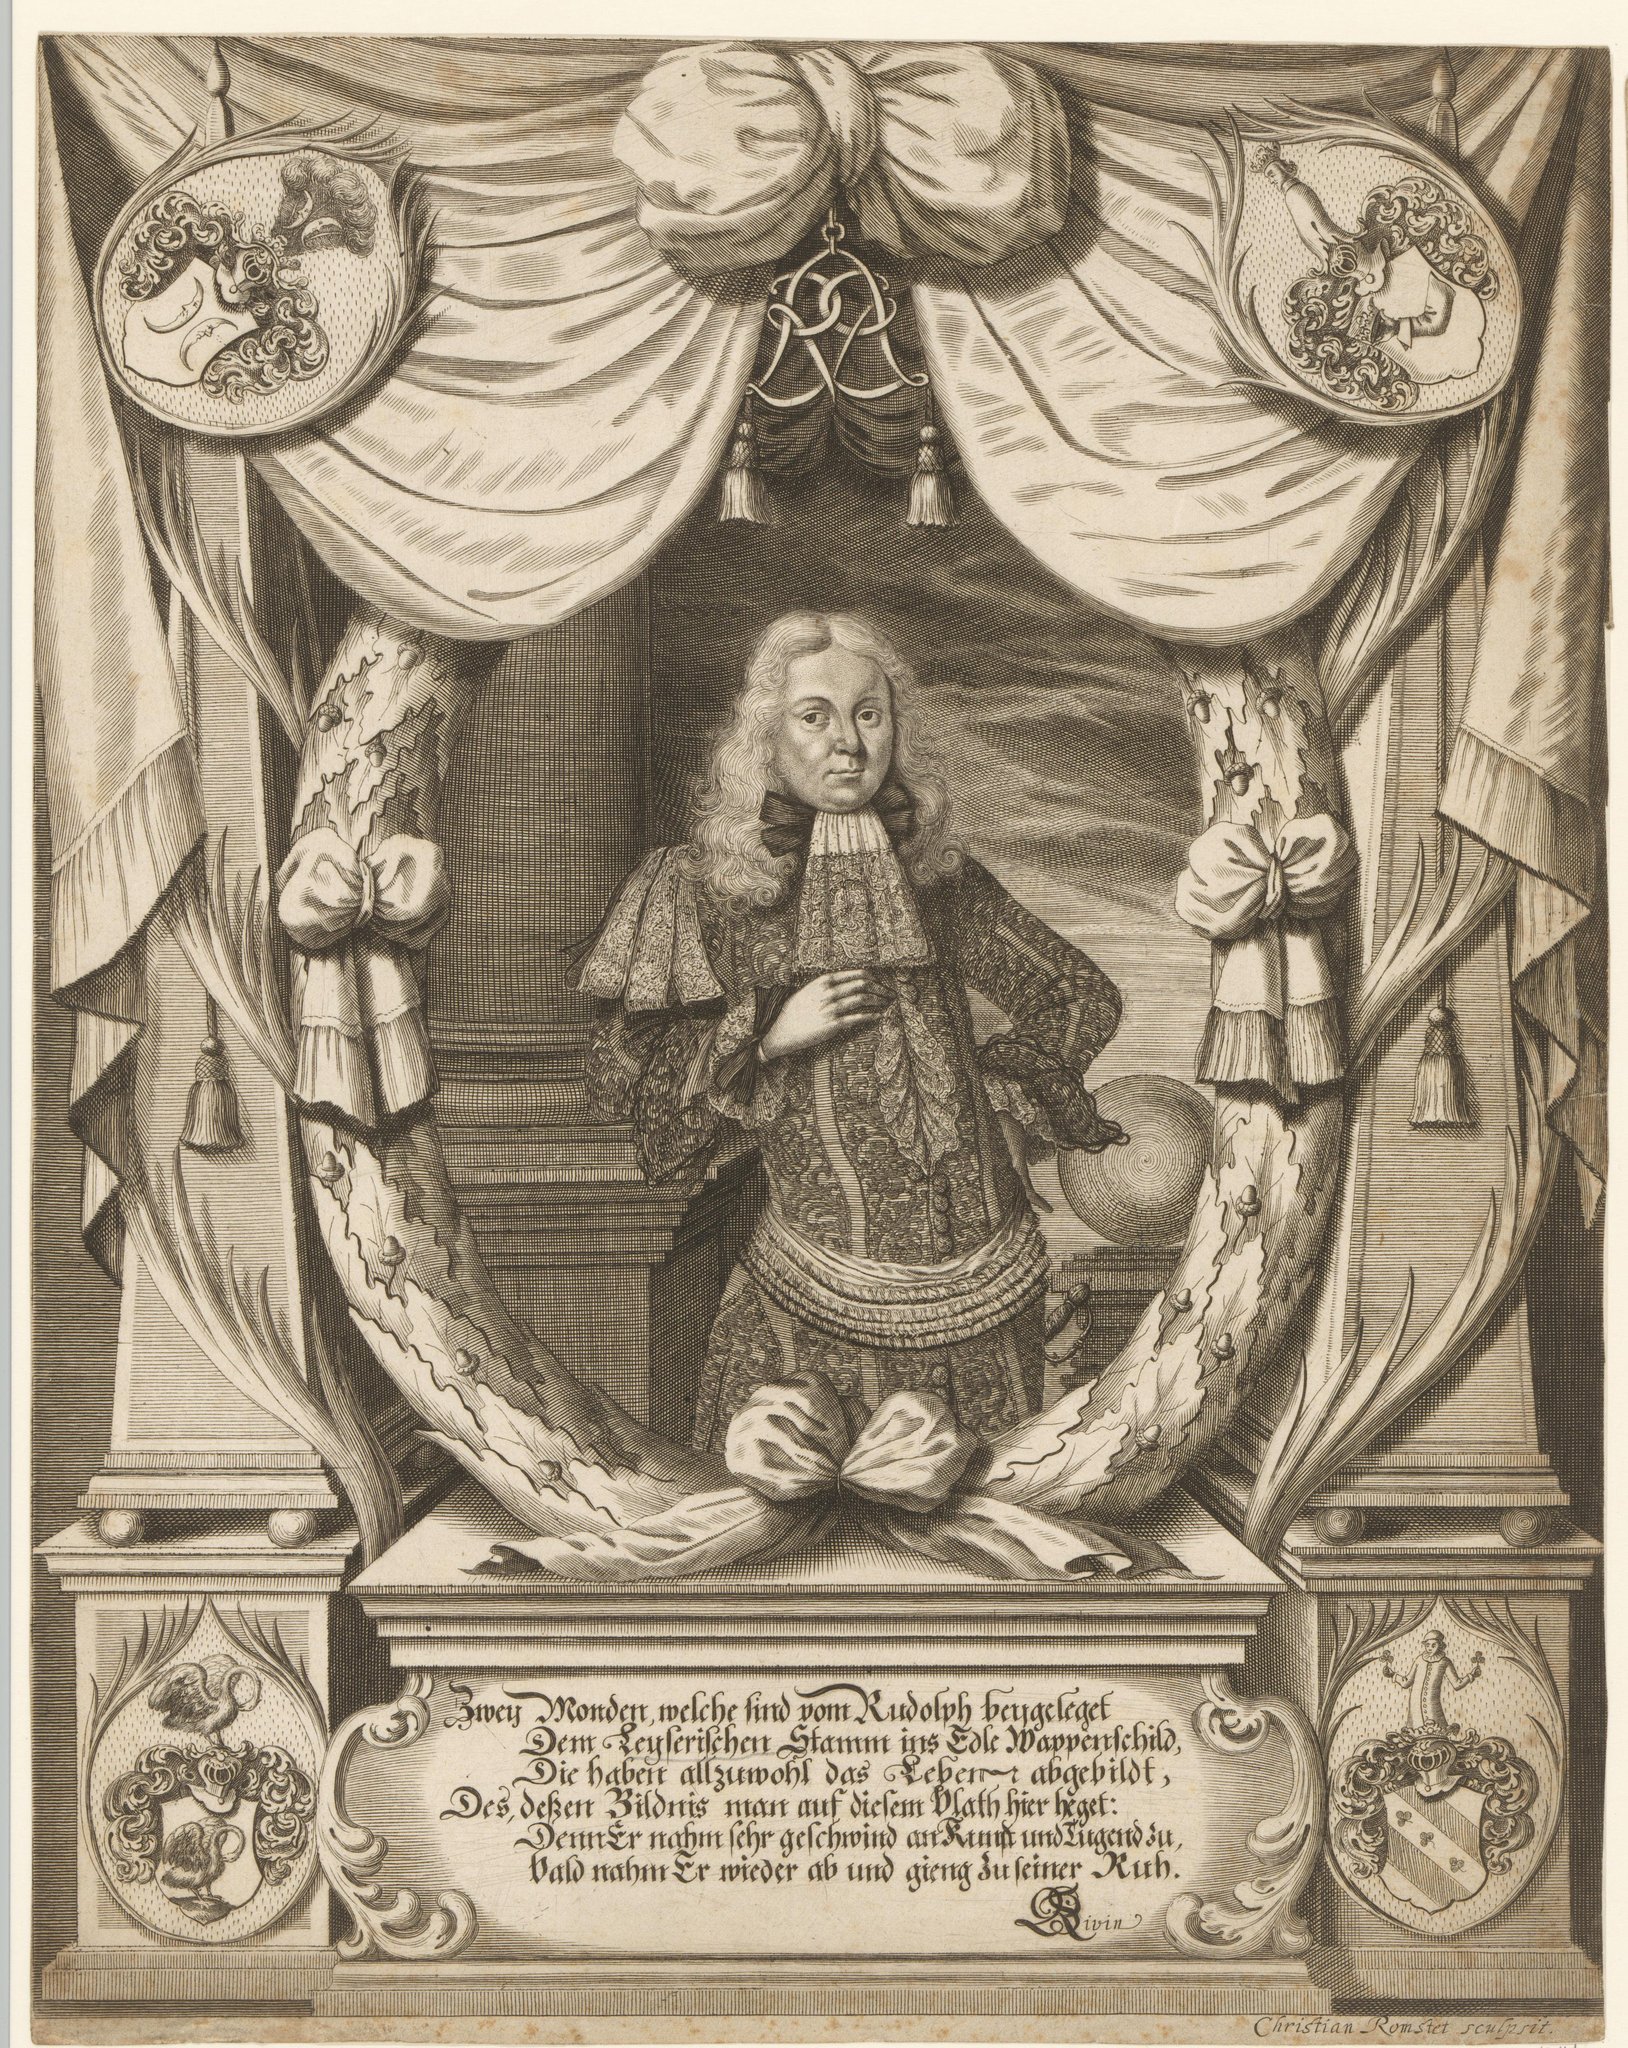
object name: print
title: Portret van Rudolph Leyser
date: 1665-1721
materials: paper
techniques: engraving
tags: historical persons, armorial bearing, heraldry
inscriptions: collector's mark: Lugt 2228